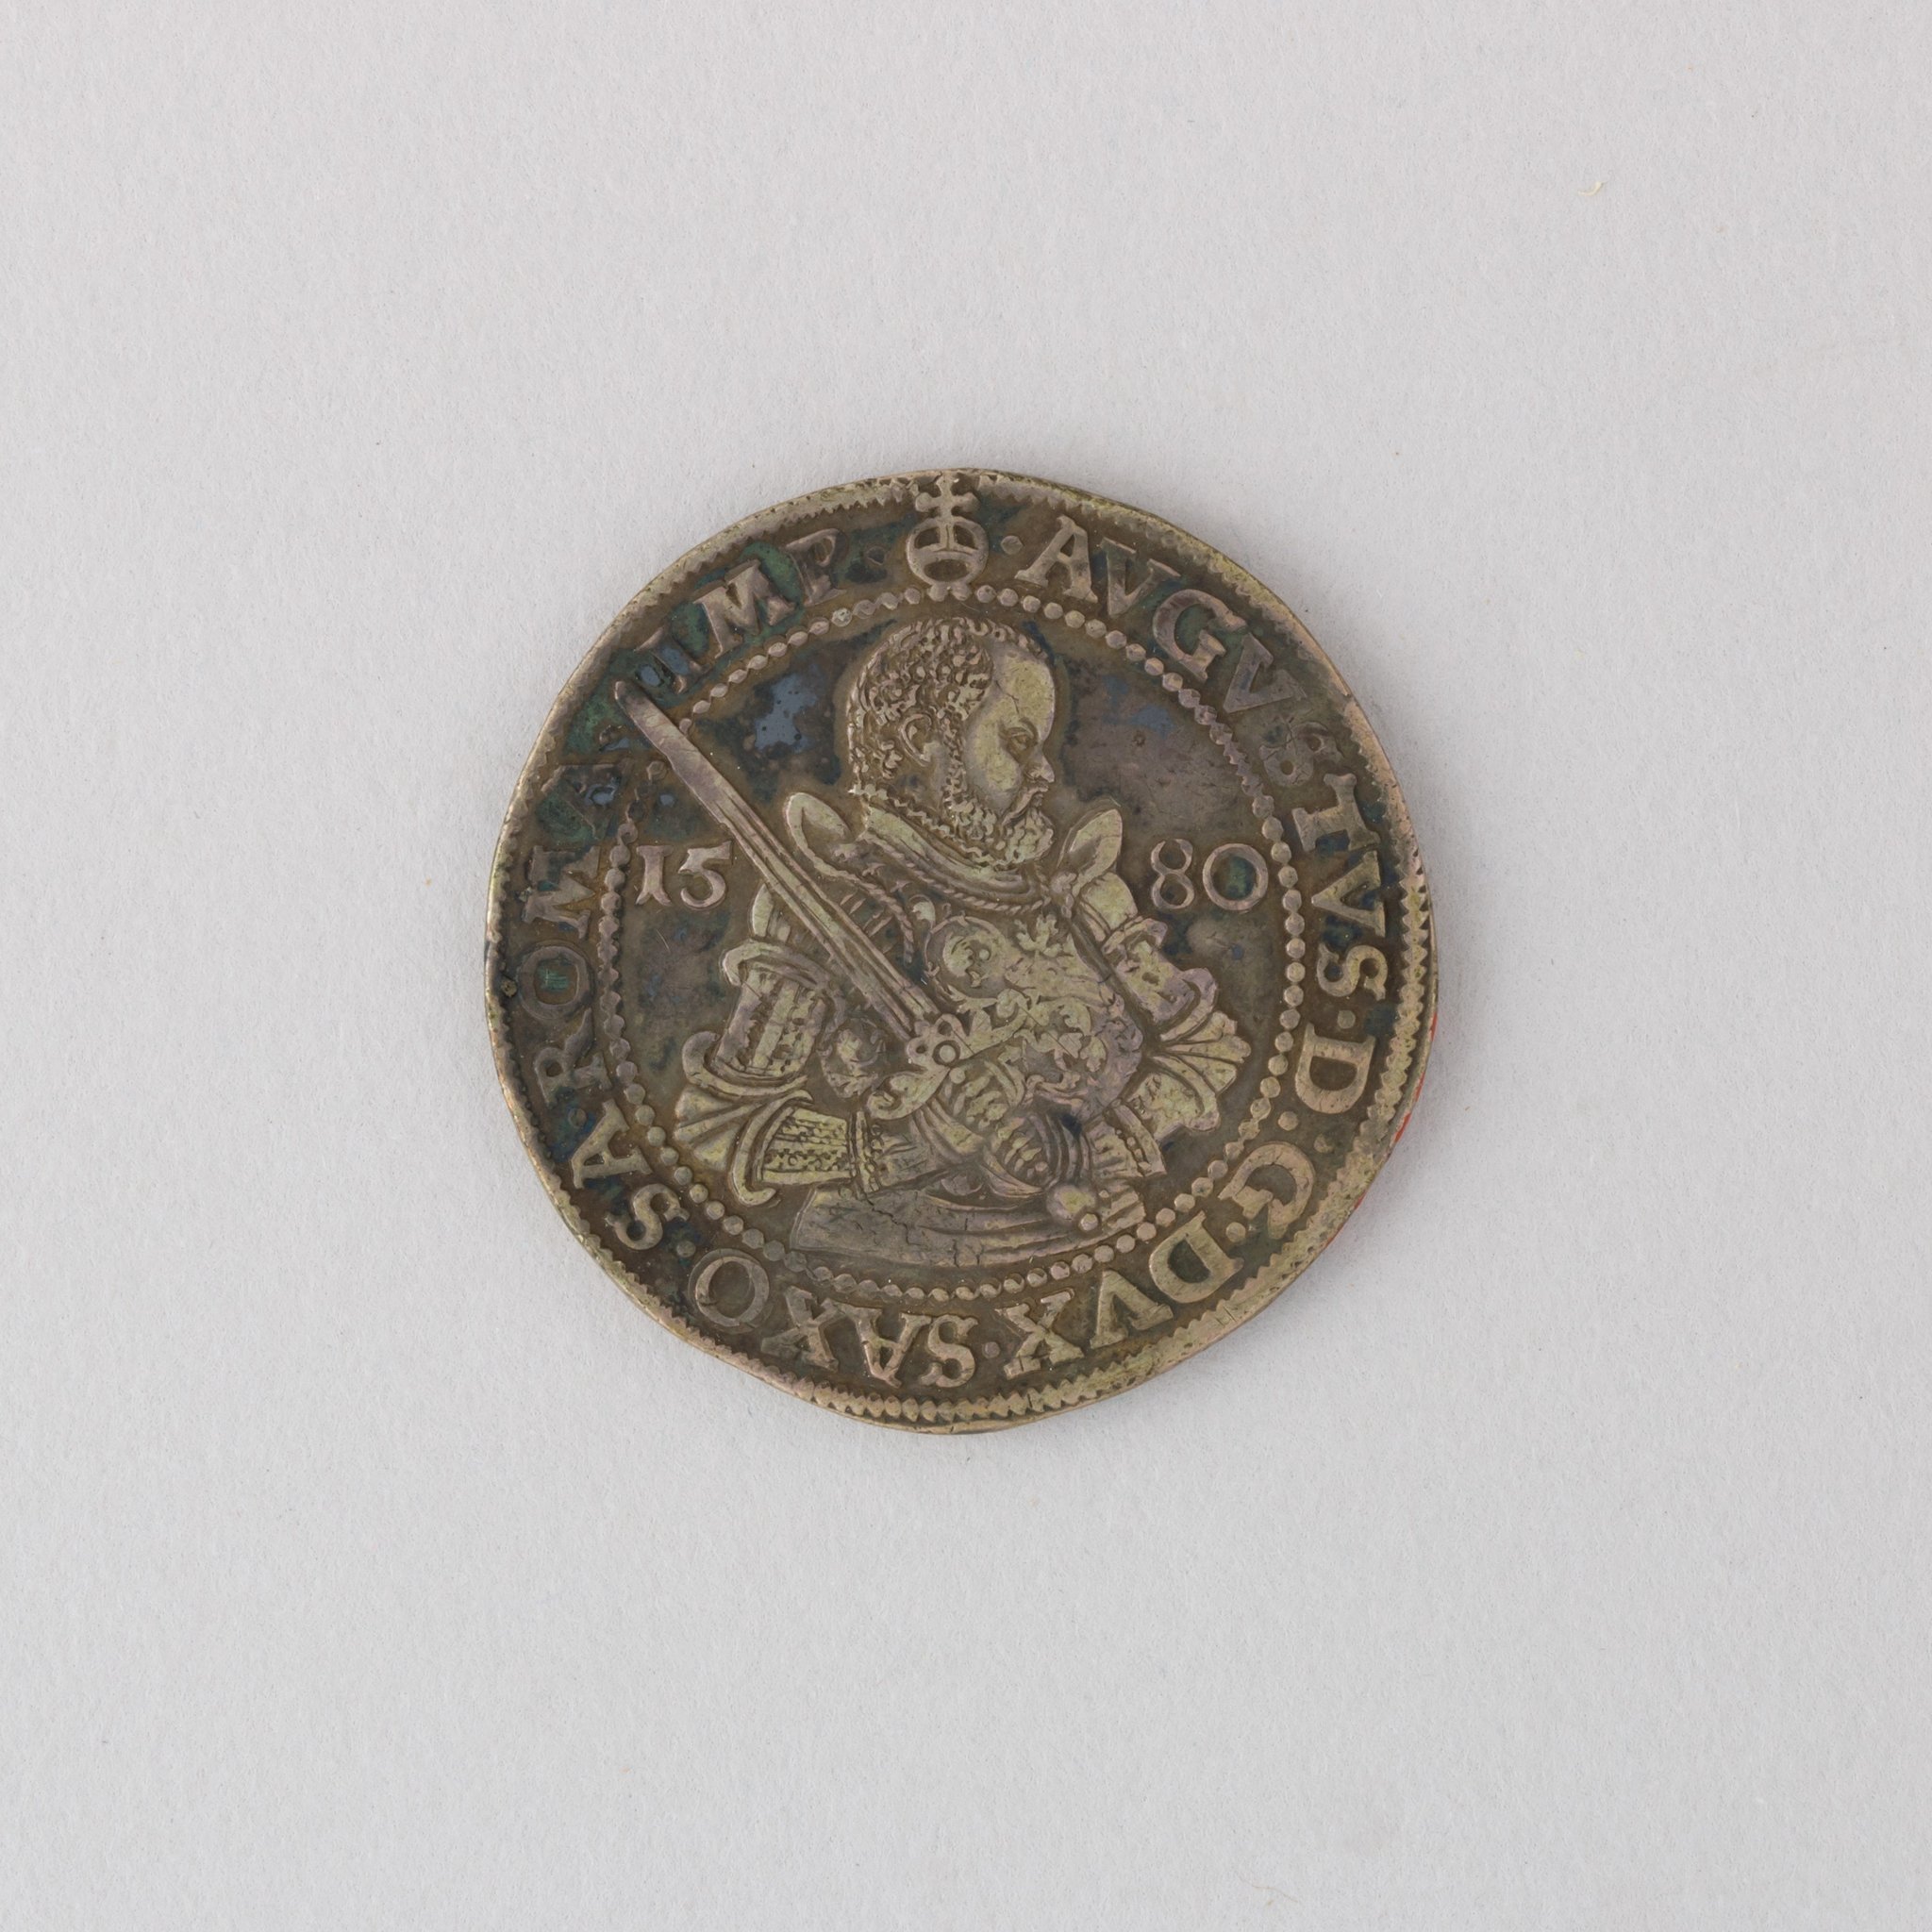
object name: coin thaler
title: Coin (Thaler) Showing August I (The Pious) of Saxony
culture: german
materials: silver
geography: germany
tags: men,coat of arms